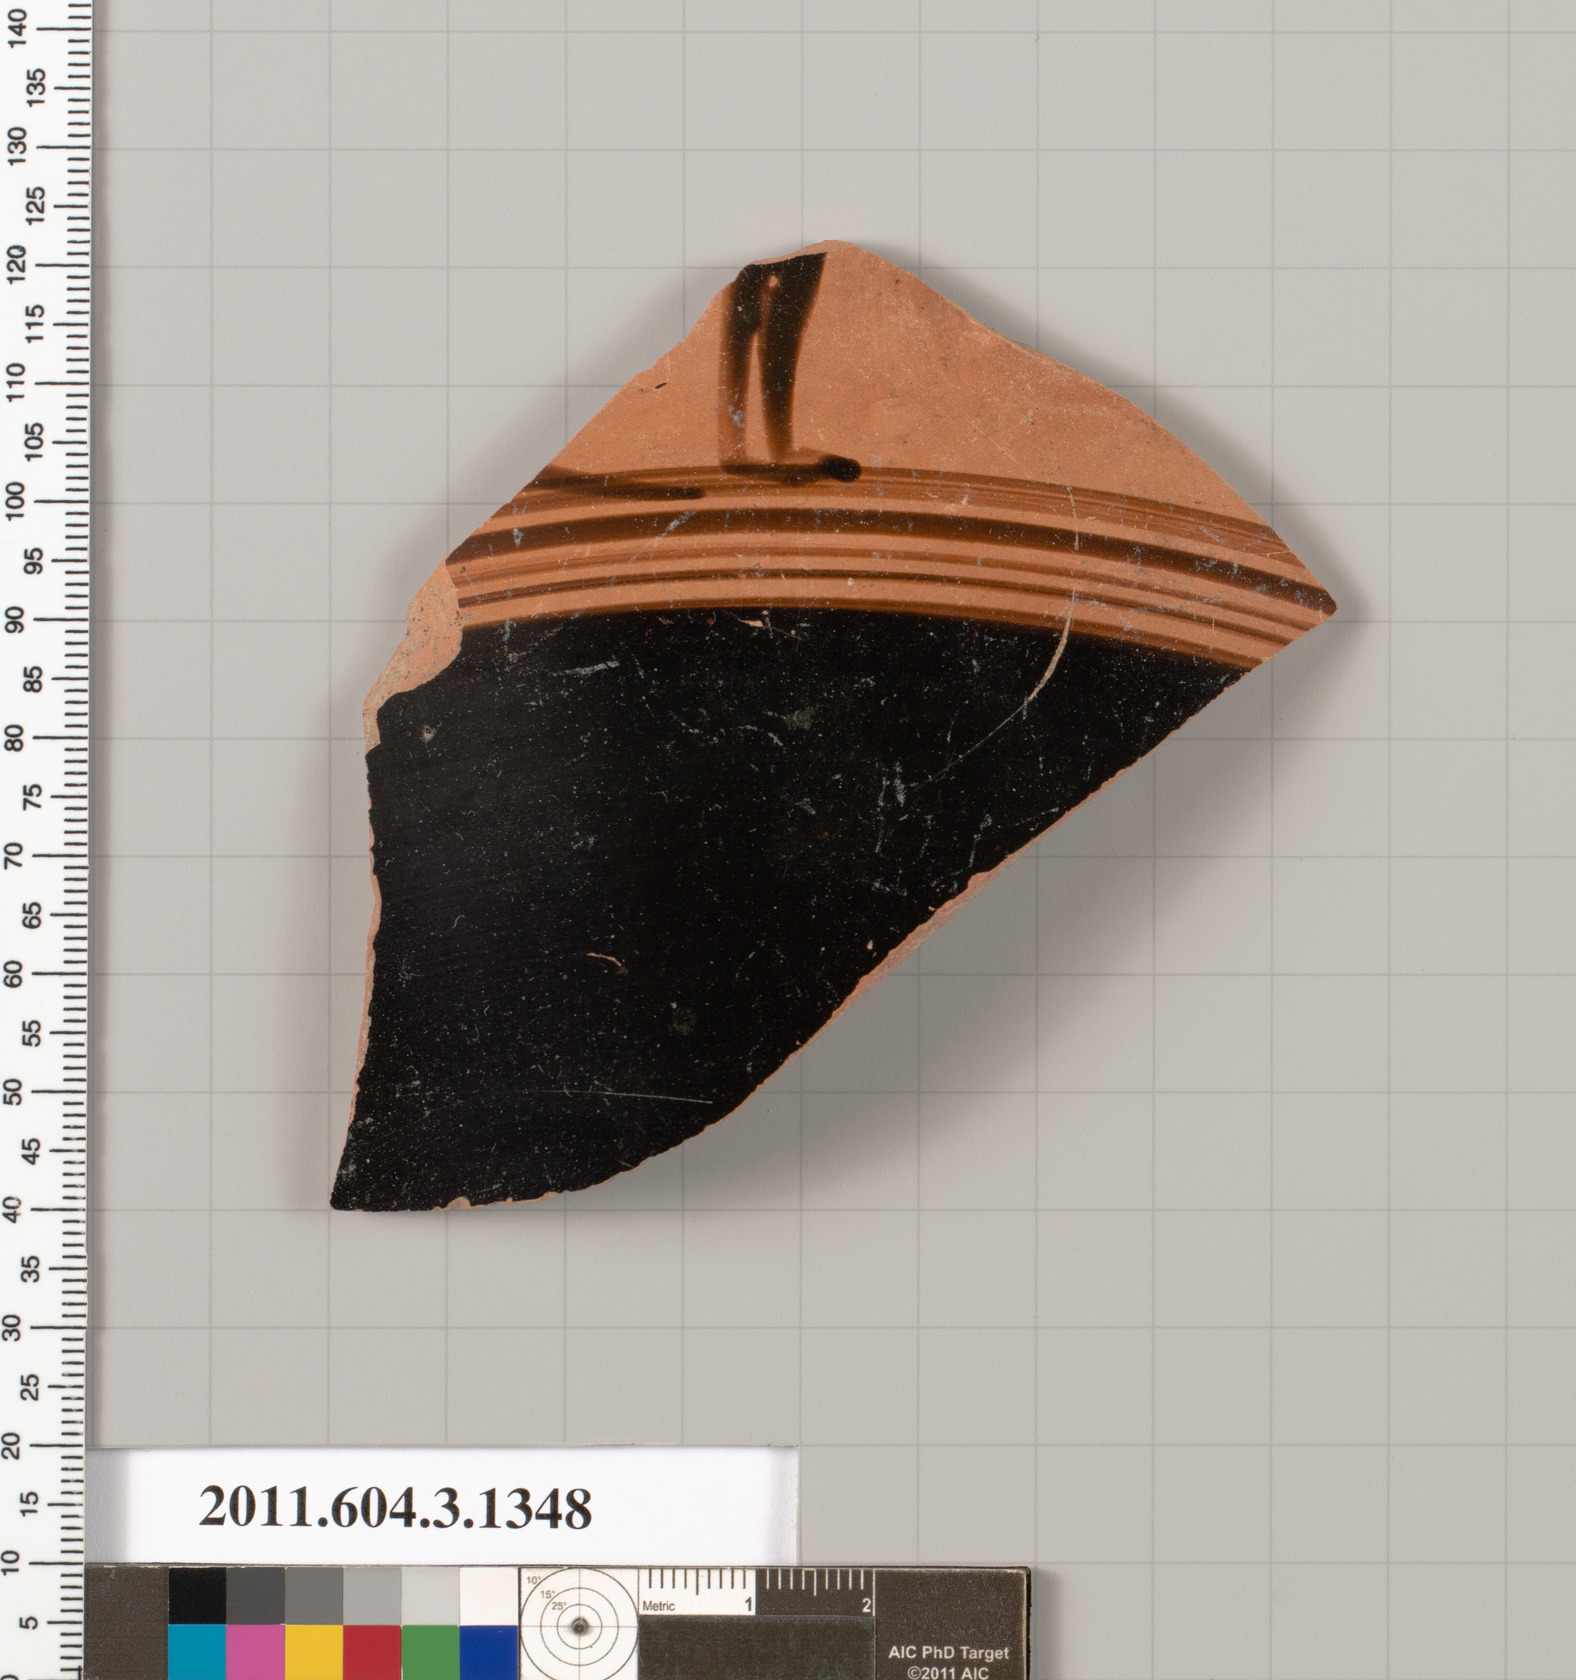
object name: skyphos fragment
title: Terracotta fragment of a skyphos (deep drinking cup)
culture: greek, attic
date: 500-468 BCE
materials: terracotta